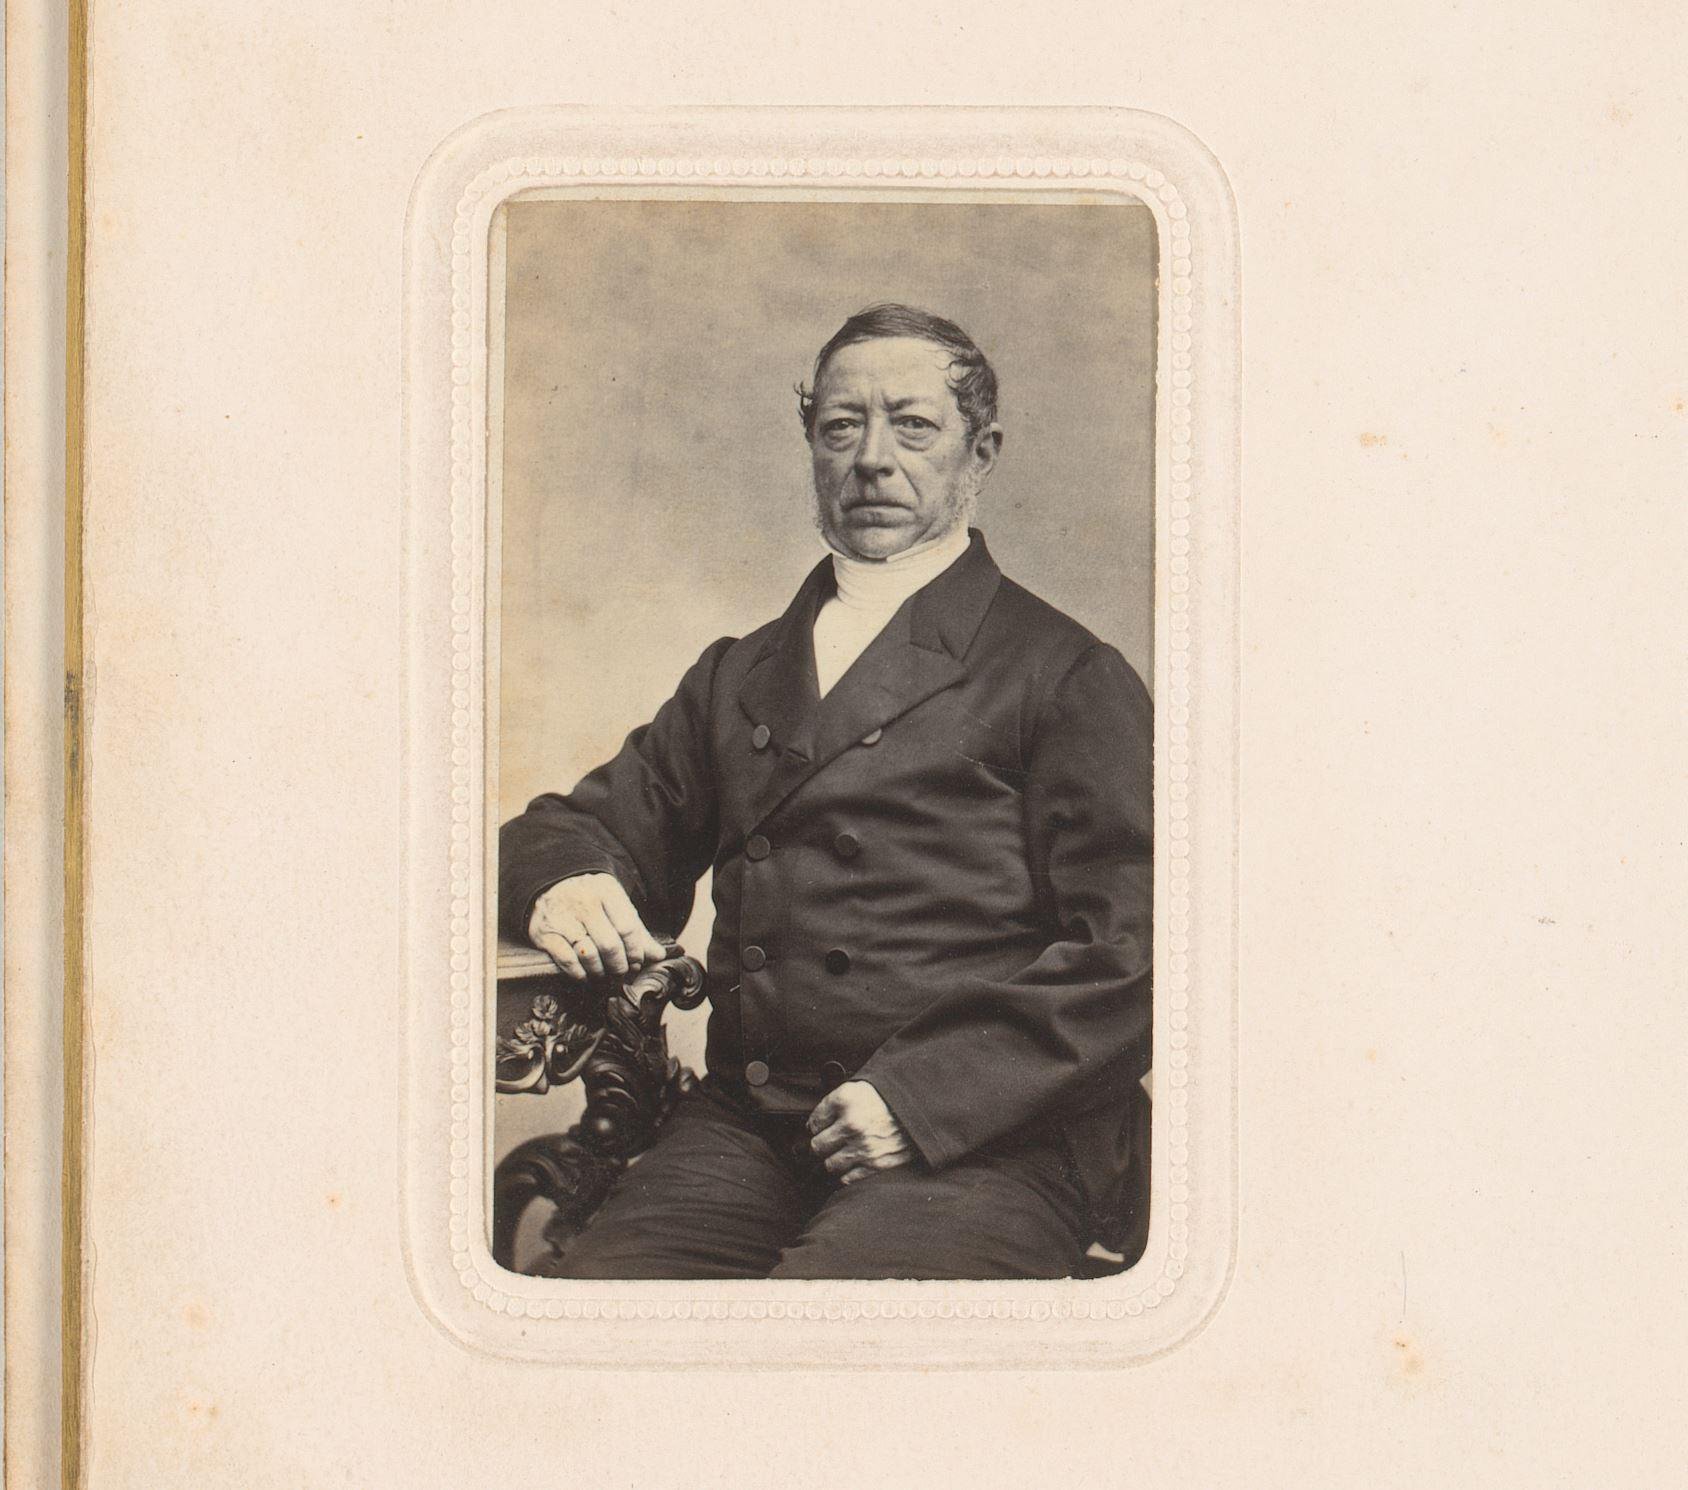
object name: photograph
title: Portret van een man, zittend aan een tafel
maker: Anonymous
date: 1855-1880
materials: cardboard, paper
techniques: albumen print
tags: sitting figure, historical persons, table